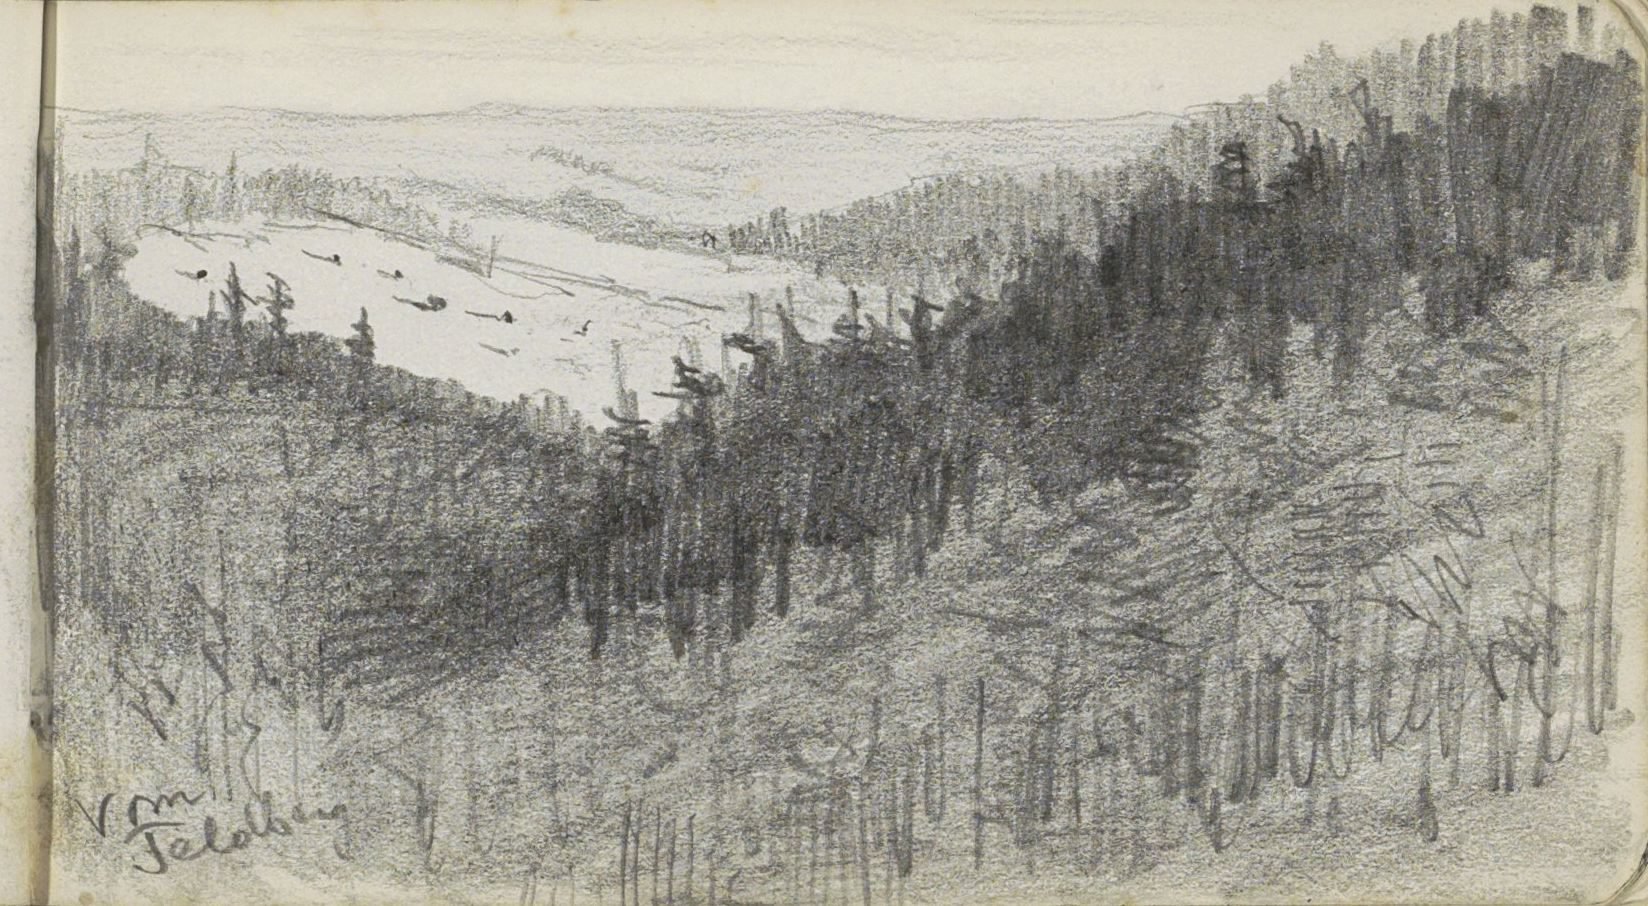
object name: sketchbook leaf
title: Gezicht op het Schwarzwald vanaf de Feldberg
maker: geo poggenbeek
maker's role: draughtsman, painter, print maker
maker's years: 1853-1903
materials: paper, pencil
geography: feldberg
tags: dale, valley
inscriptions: annotation: ‘vom Feldberg’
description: Blad 49 recto uit een schetsboek met 69 bladen.